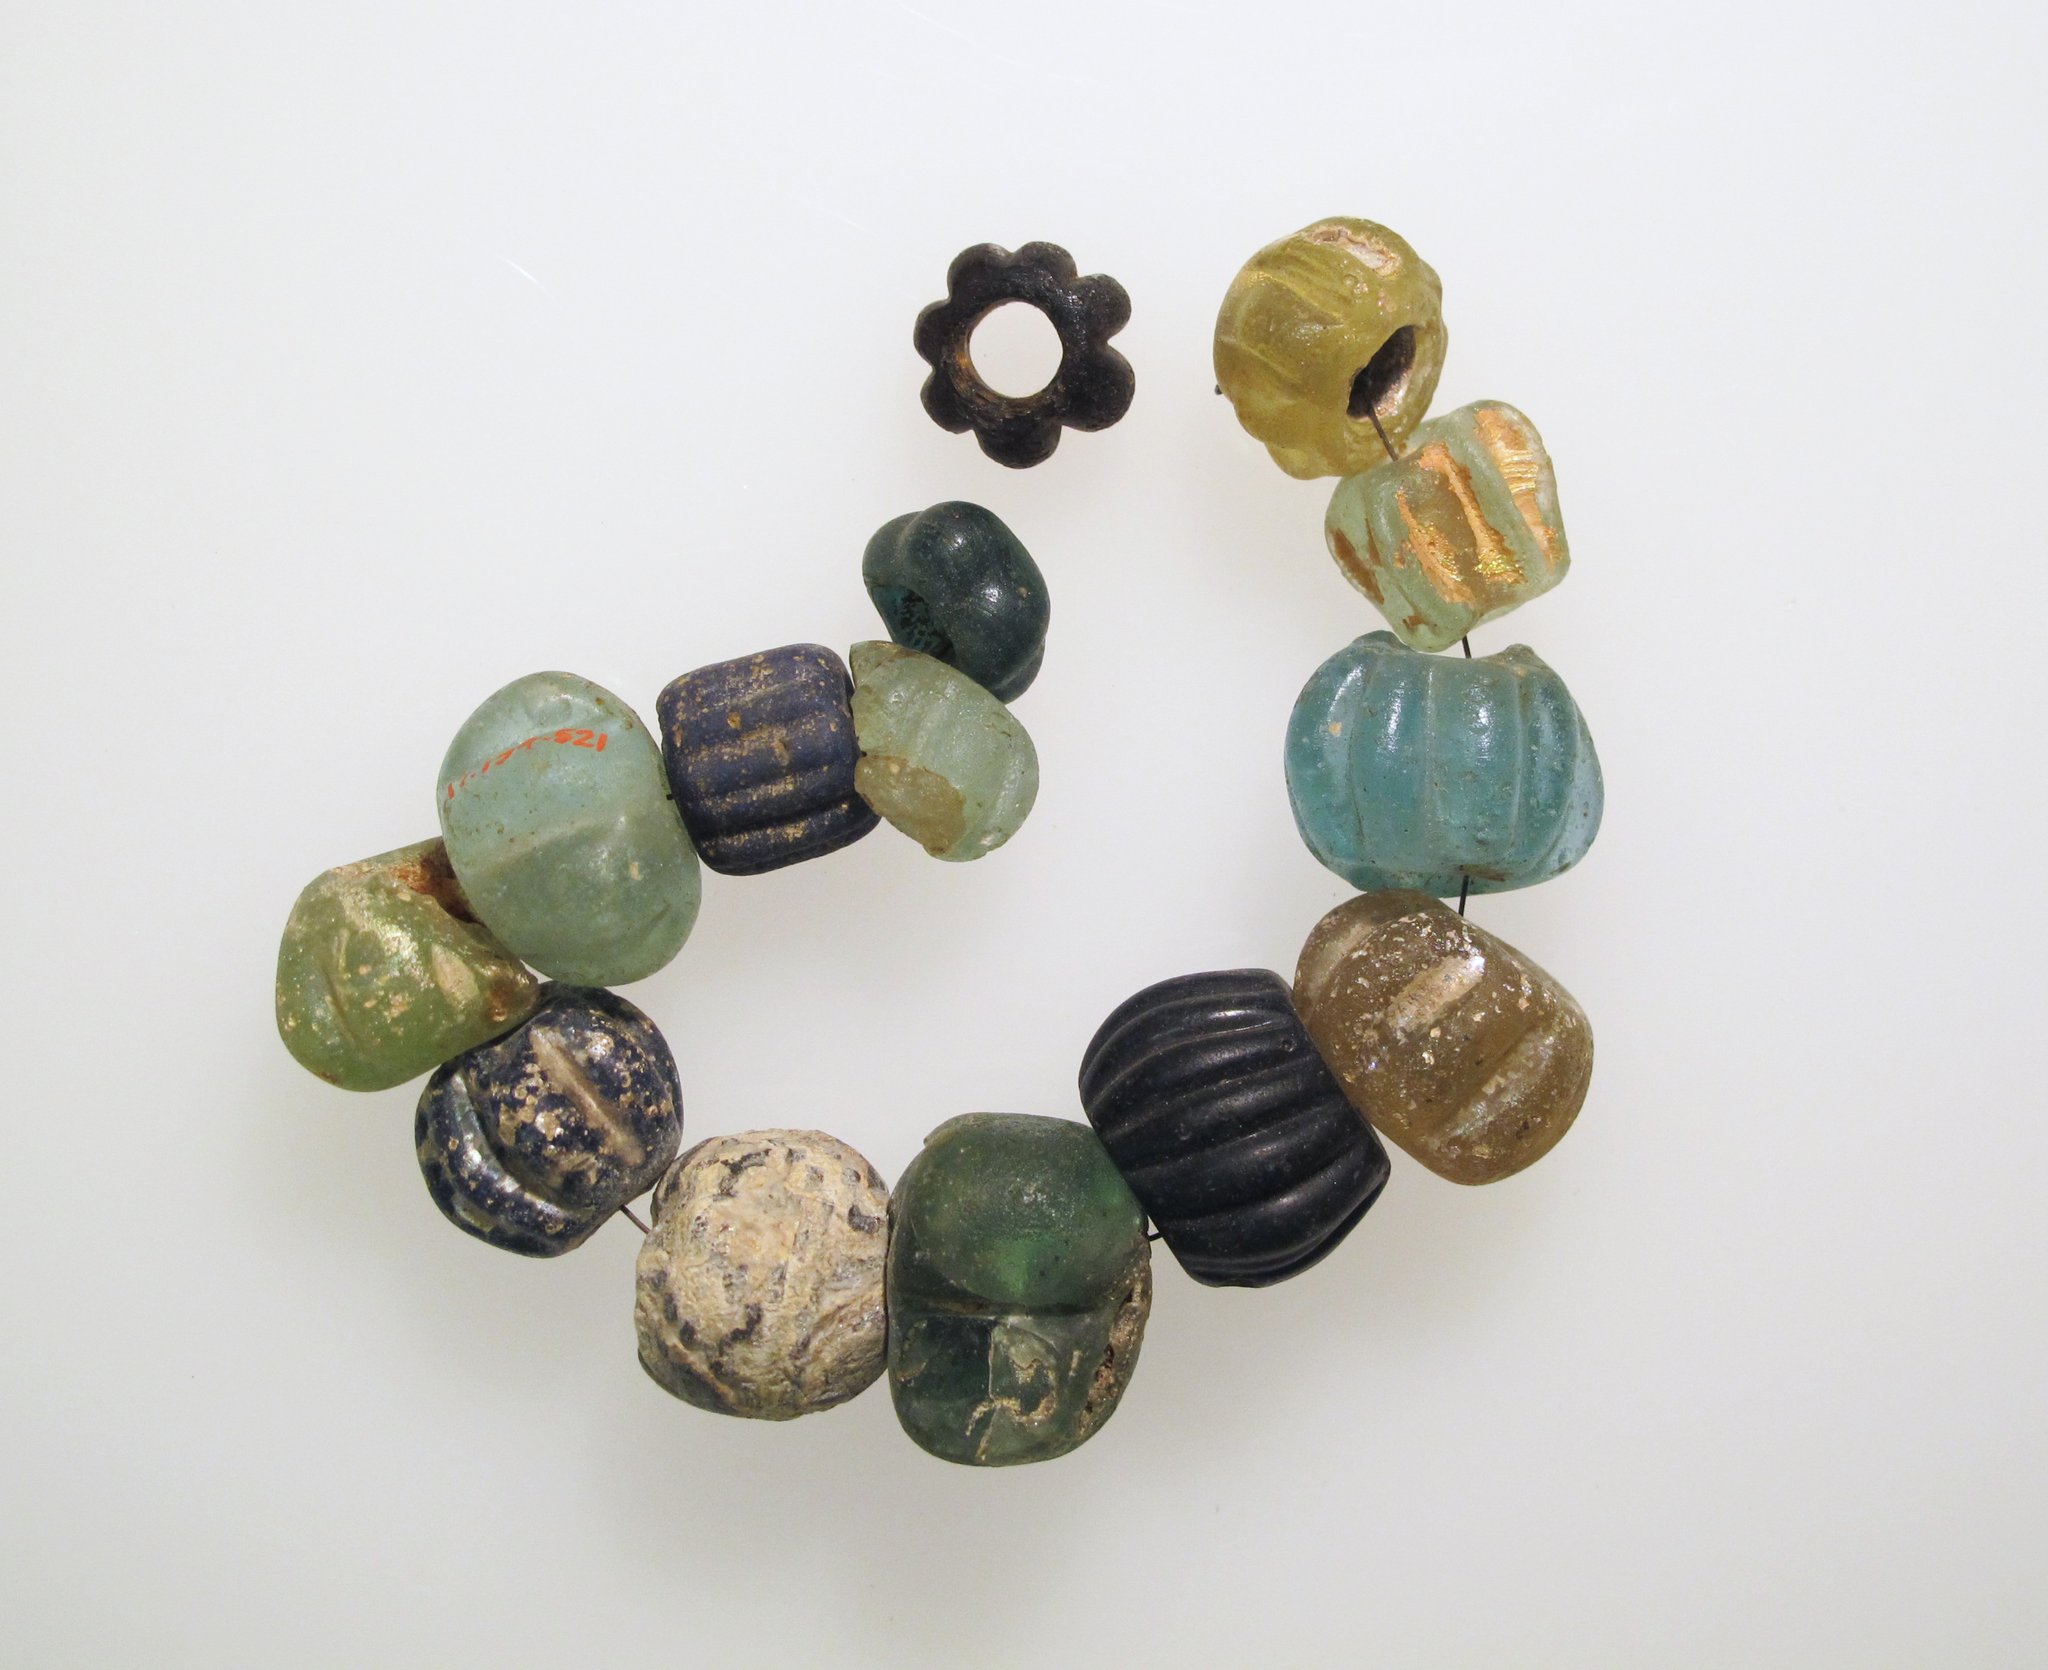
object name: bead, 14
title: Beads, 14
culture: roman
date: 670 BCE-330 CE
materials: glass